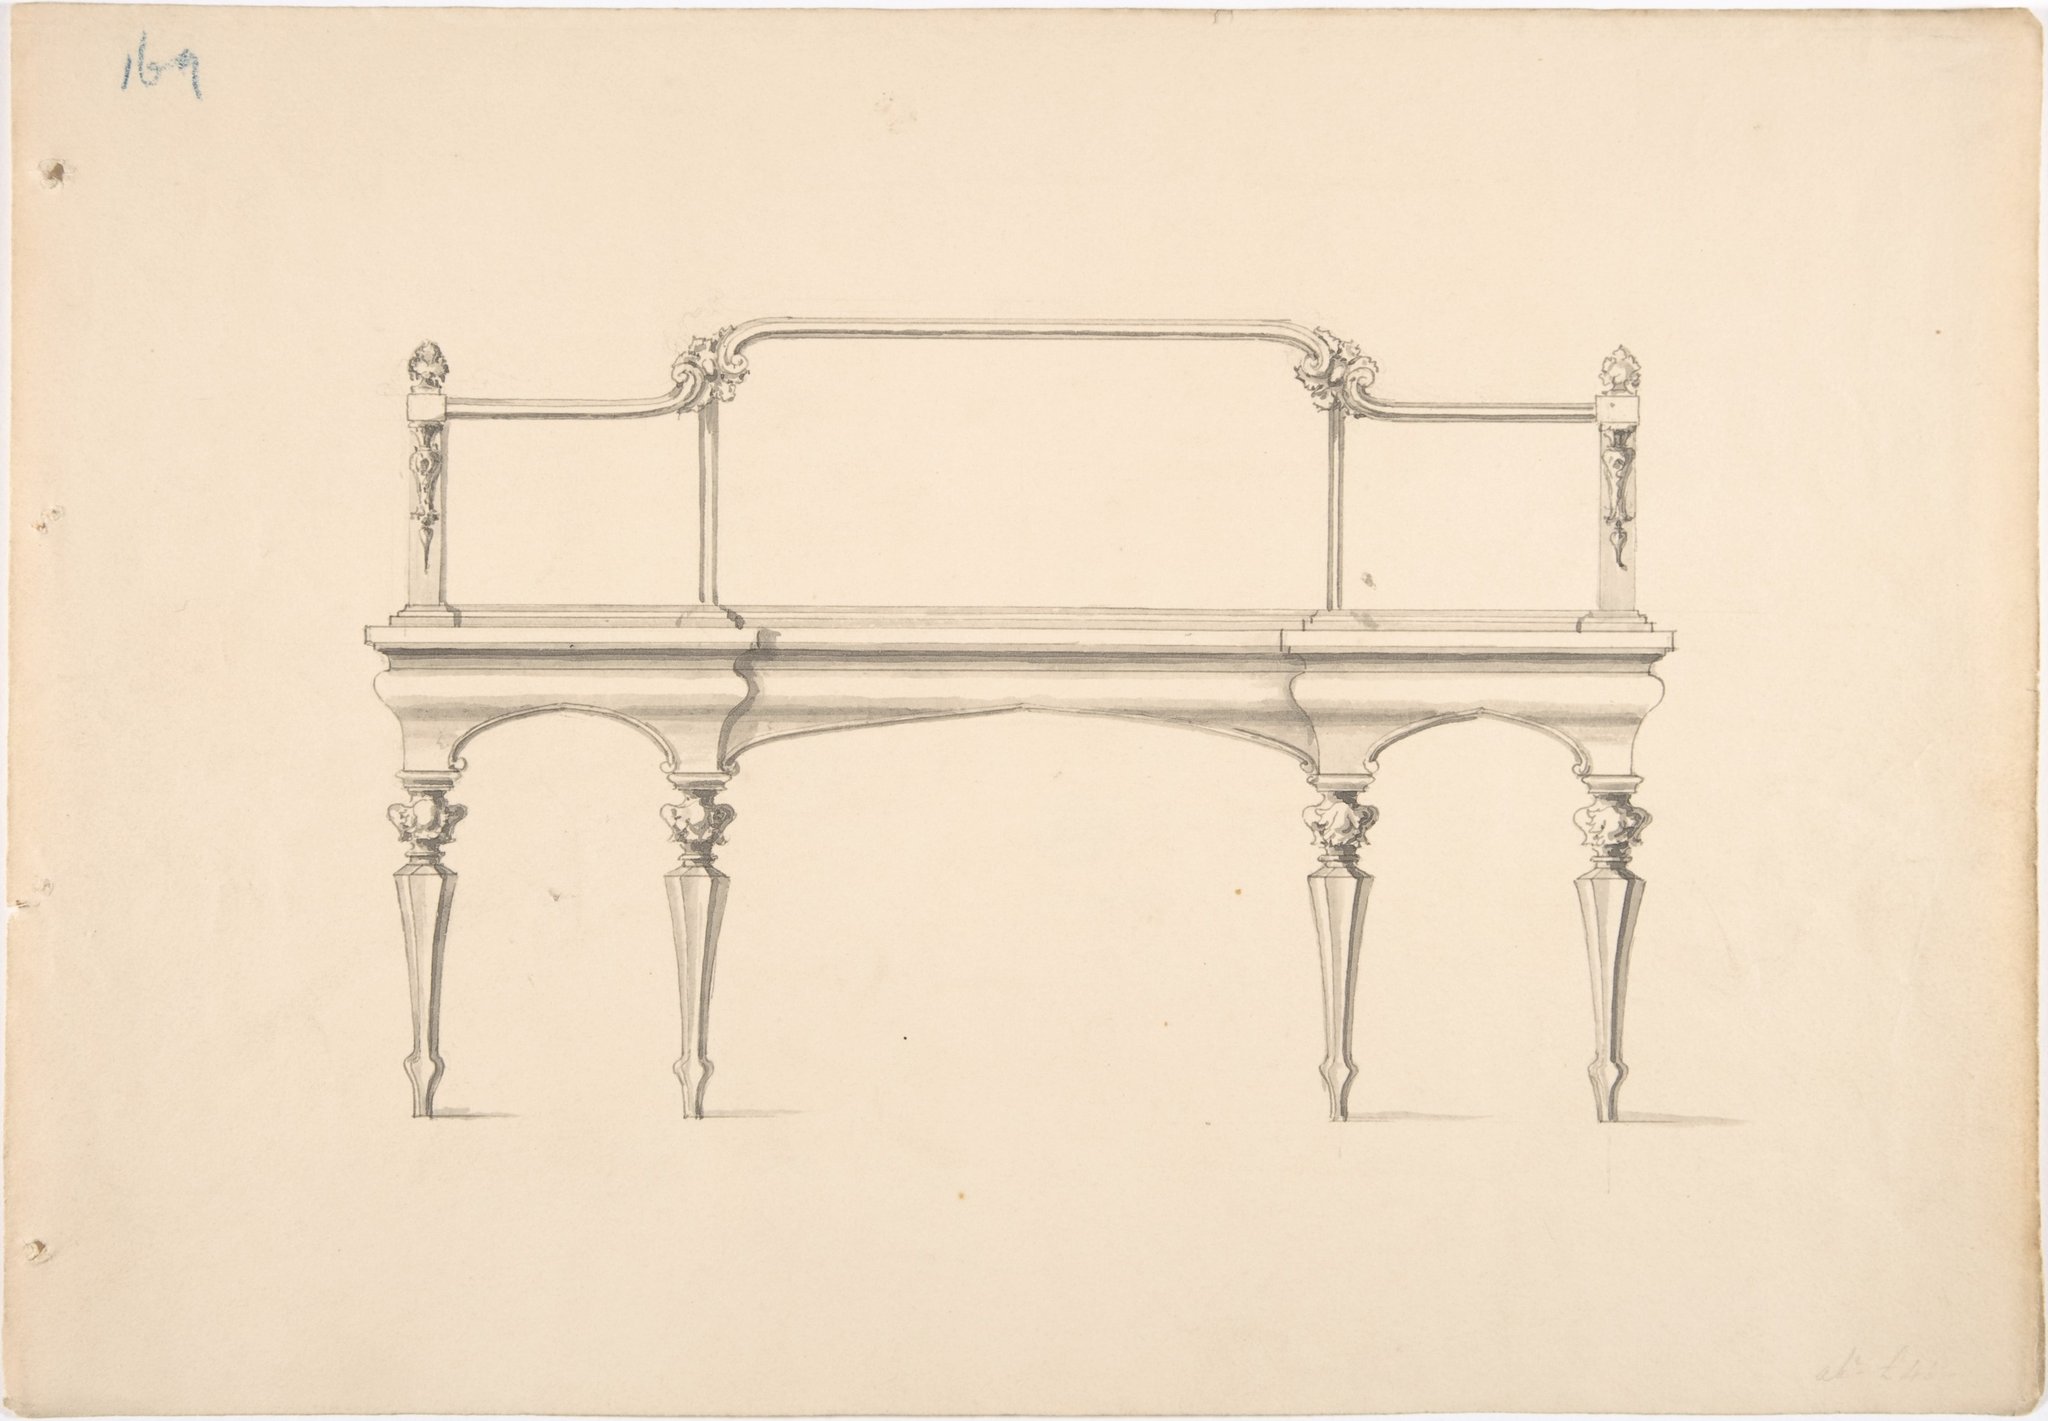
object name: drawing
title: Design for a Mirrored Sideboard with Pointed Legs and Foliate Ornament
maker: anonymous, british, 19th century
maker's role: artist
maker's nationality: british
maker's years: 1800-1900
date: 1801-1833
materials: ink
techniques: brush, pen, wash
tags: furniture